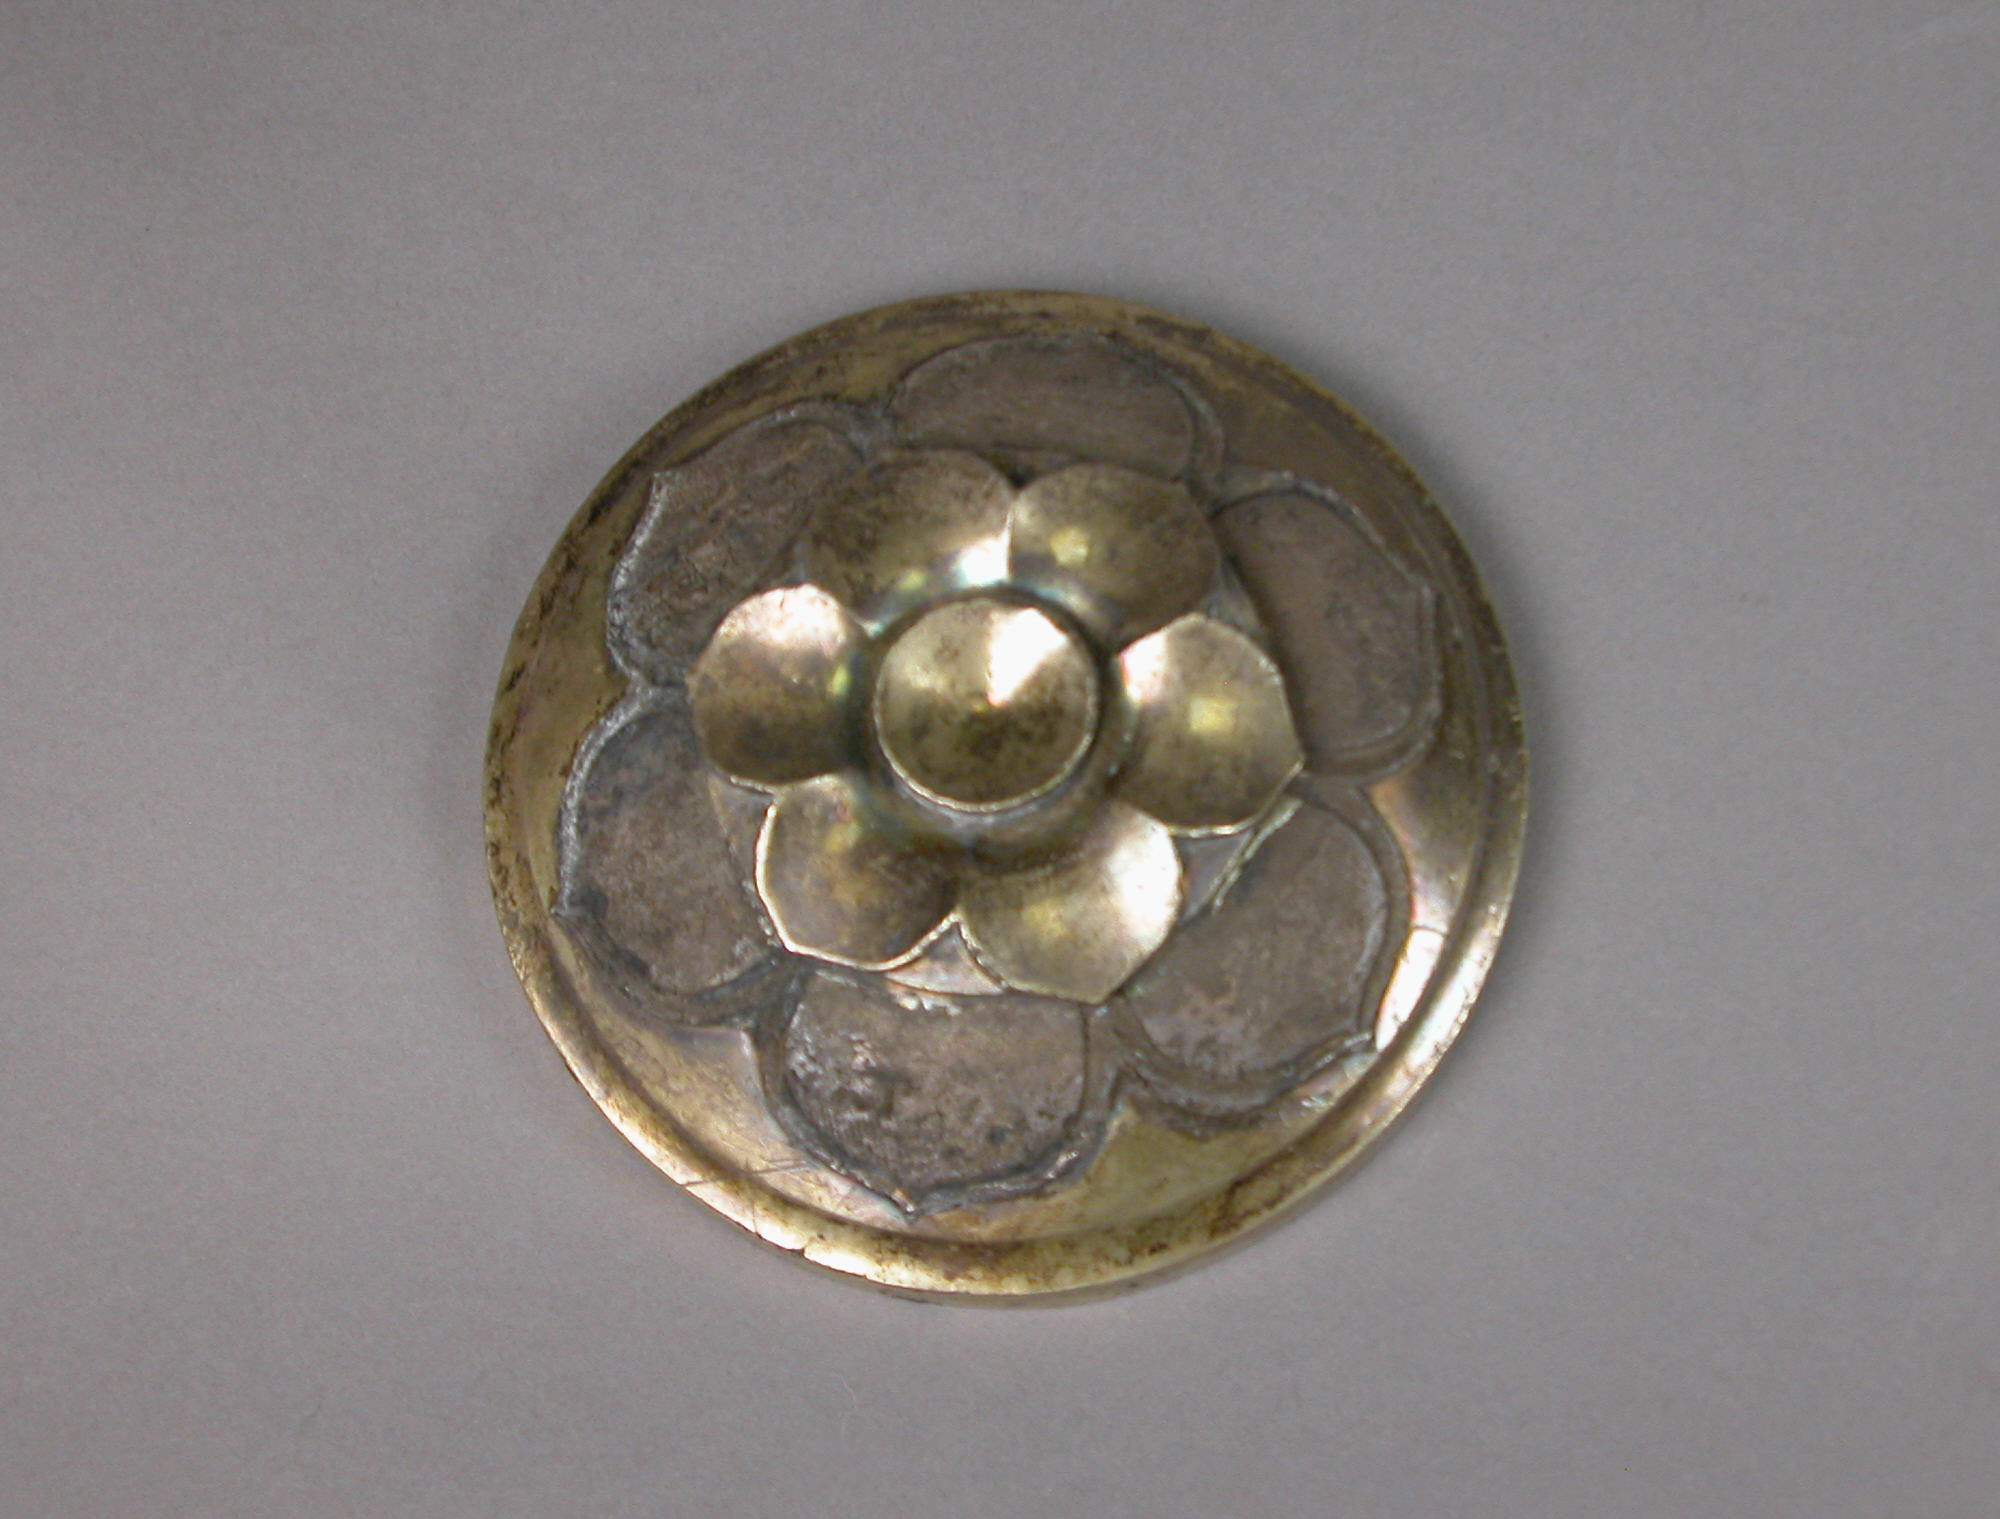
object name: bowl with cover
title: Bowl cover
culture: chinese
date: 618-907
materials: gilt bronze